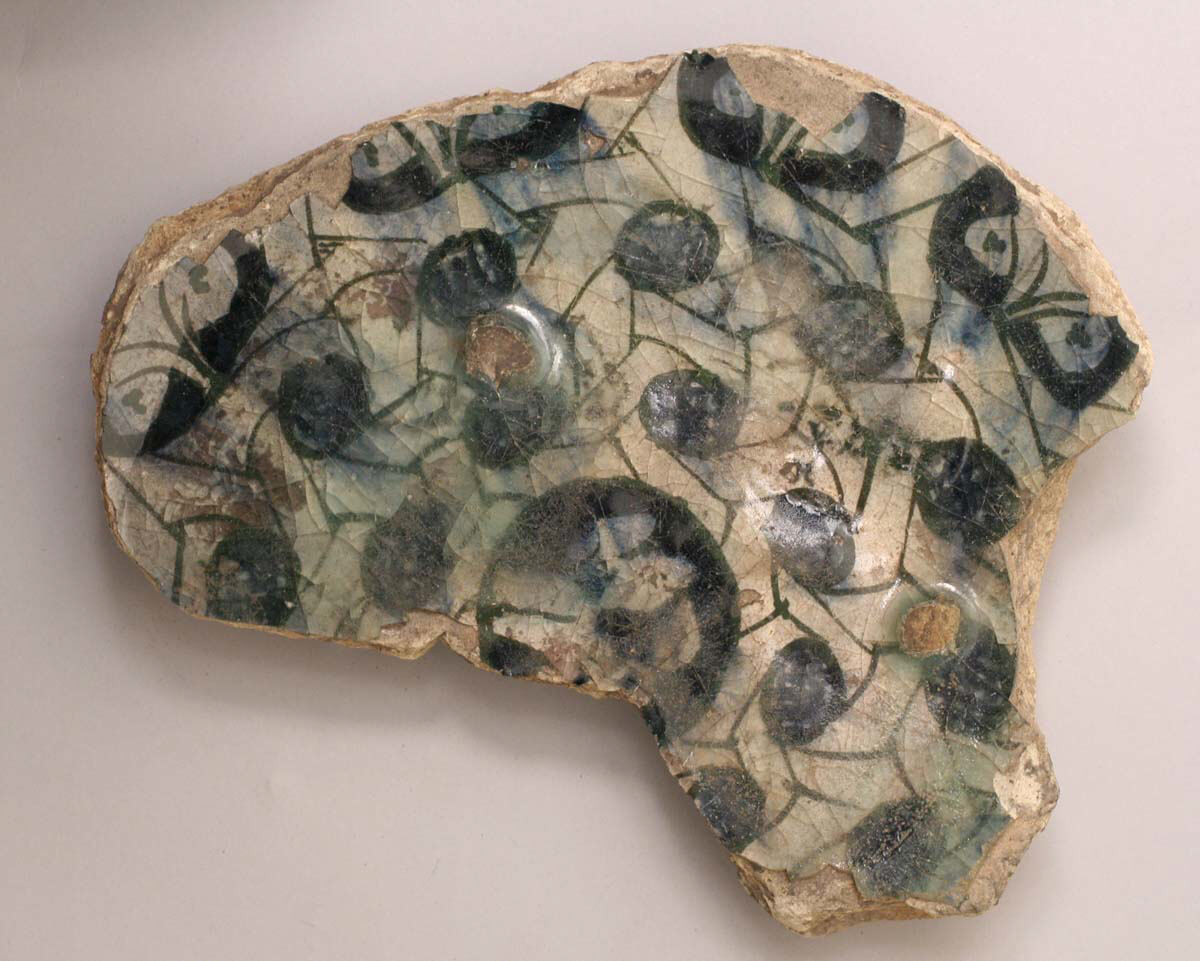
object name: fragment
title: Fragment of a Bowl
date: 1301-1500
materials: glaze, stonepaste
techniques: underglaze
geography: egypt